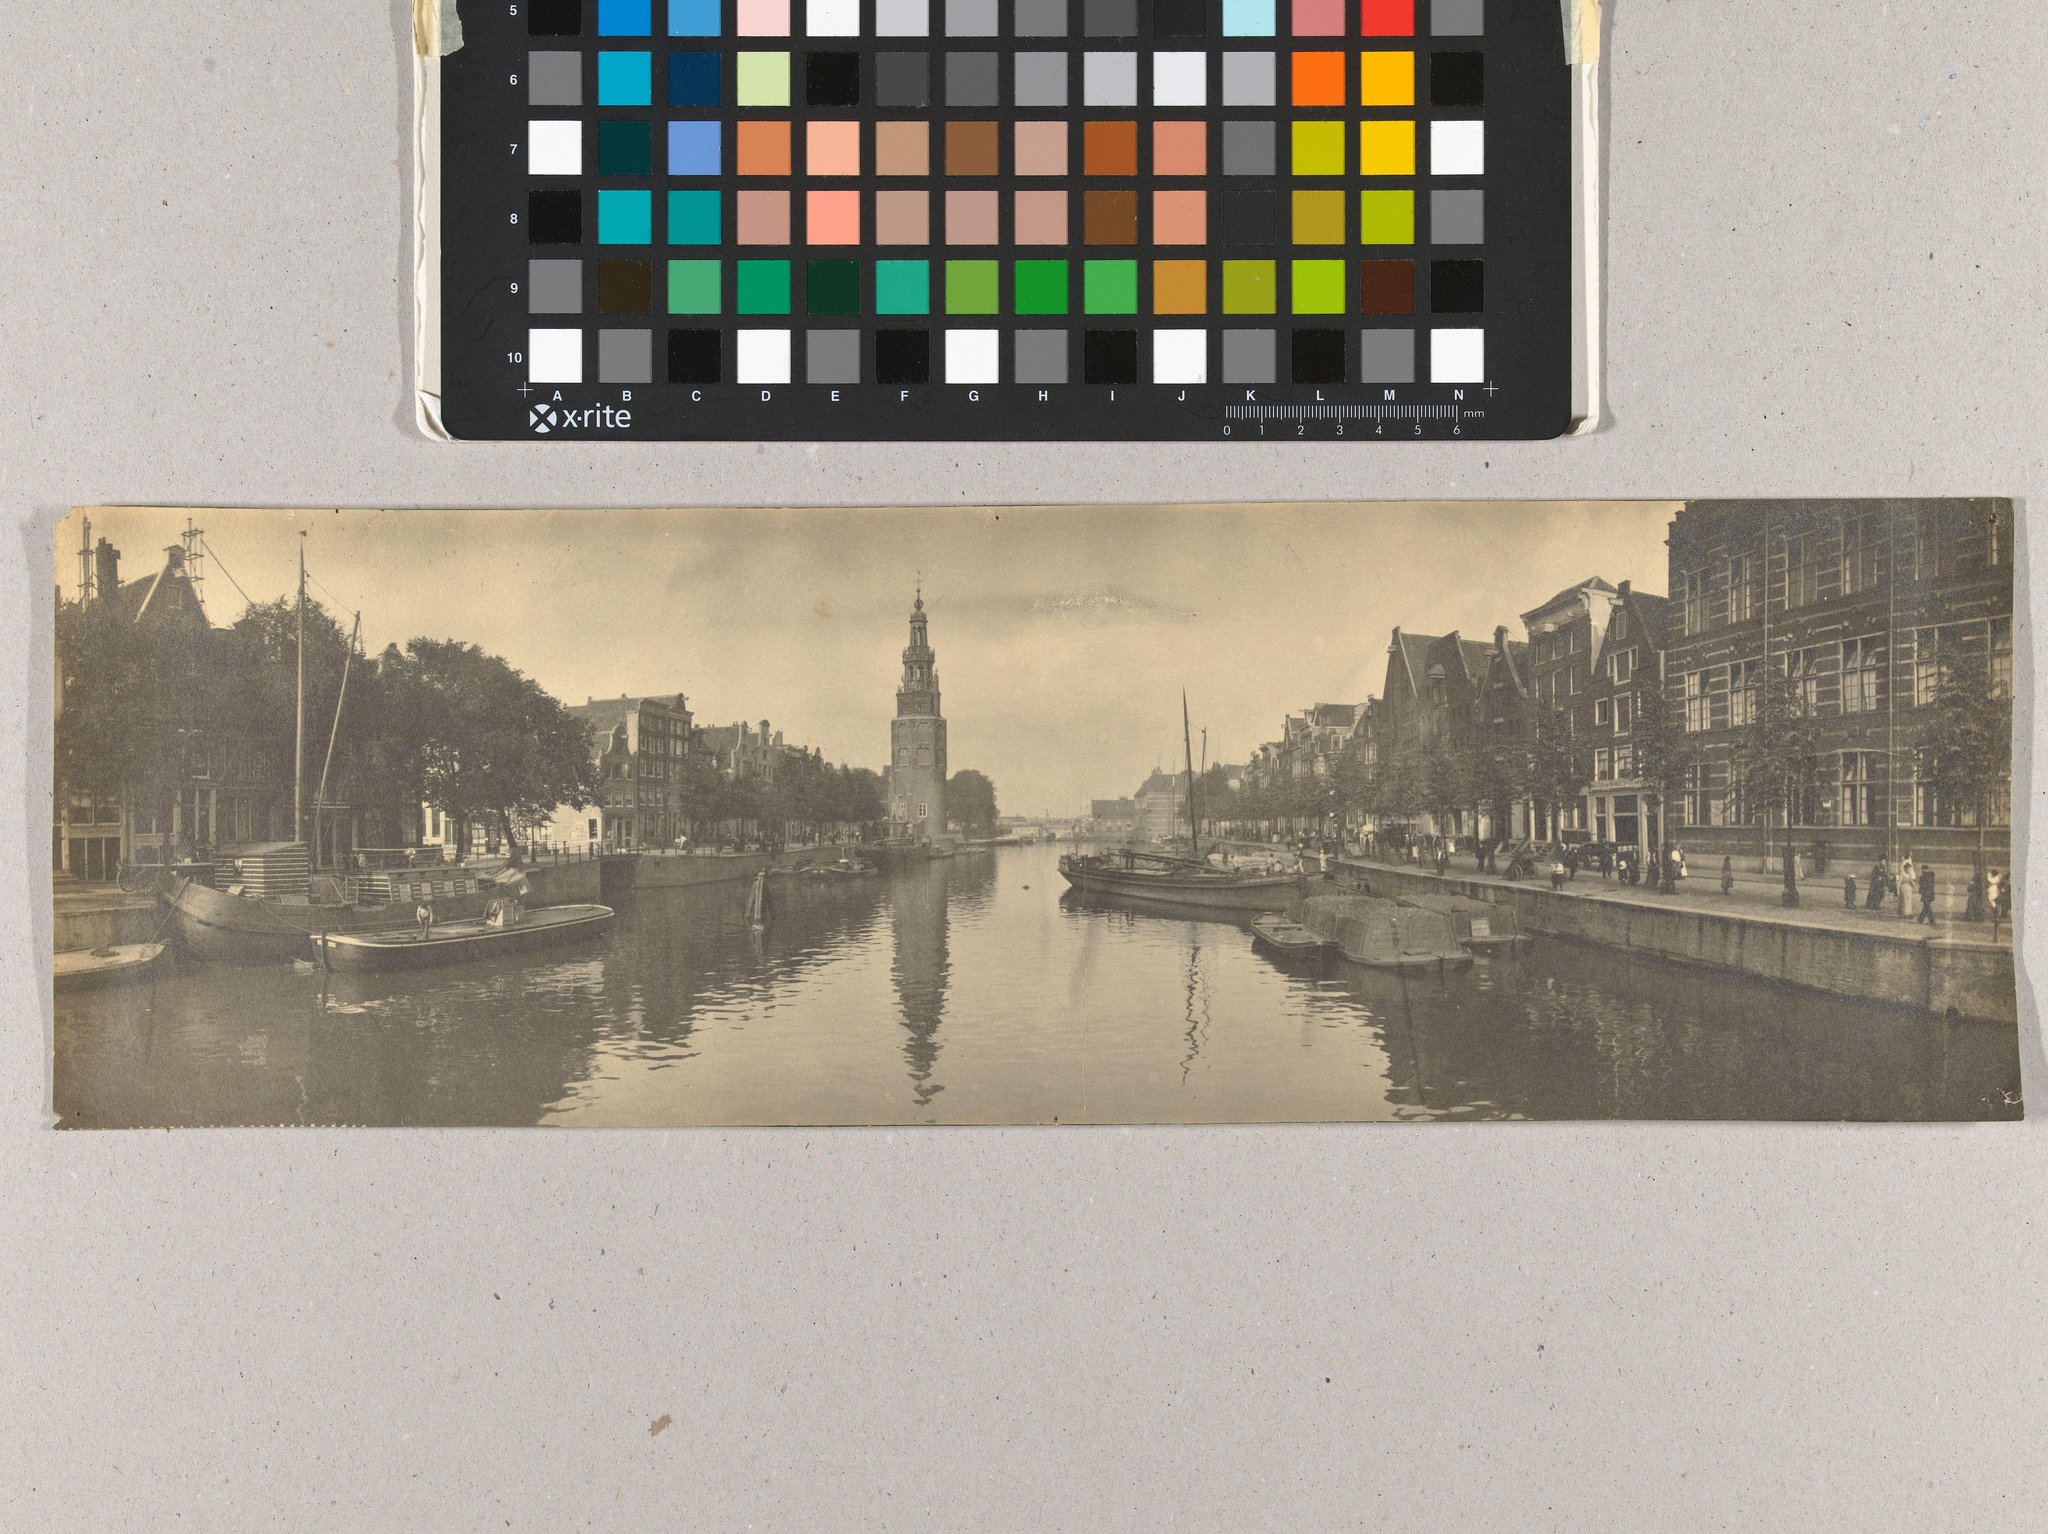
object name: photograph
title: Gezicht op de Oude Schans en de Montelbaanstoren, gezien richting het IJ, Amsterdam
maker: alb. kapteijn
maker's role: amateurfotograaf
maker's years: 1848-1927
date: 1900-1925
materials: cardboard, paper, photographic support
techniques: gelatin silver print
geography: netherlands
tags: canals, waters (in city)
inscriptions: annotation: ‘A//20 F22 E32" / left corner 27"’